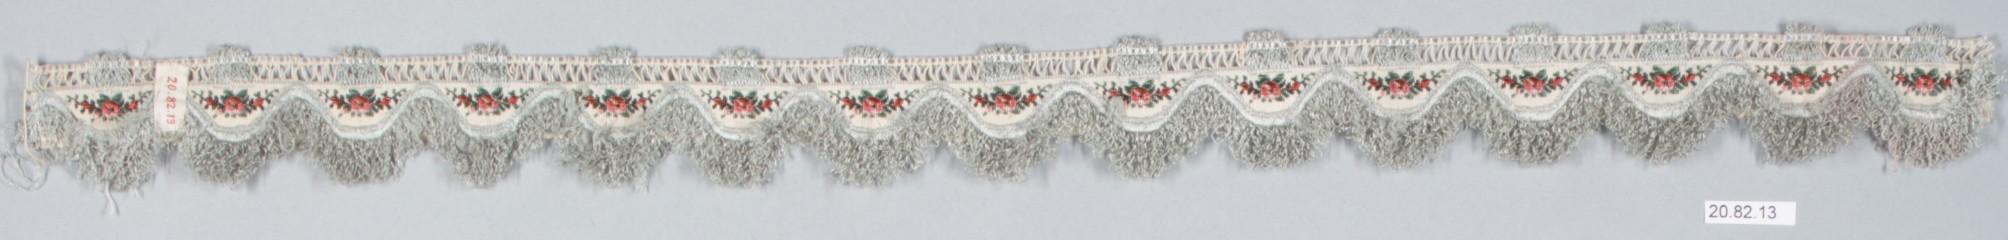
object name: ribbon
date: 1801-1833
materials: silk